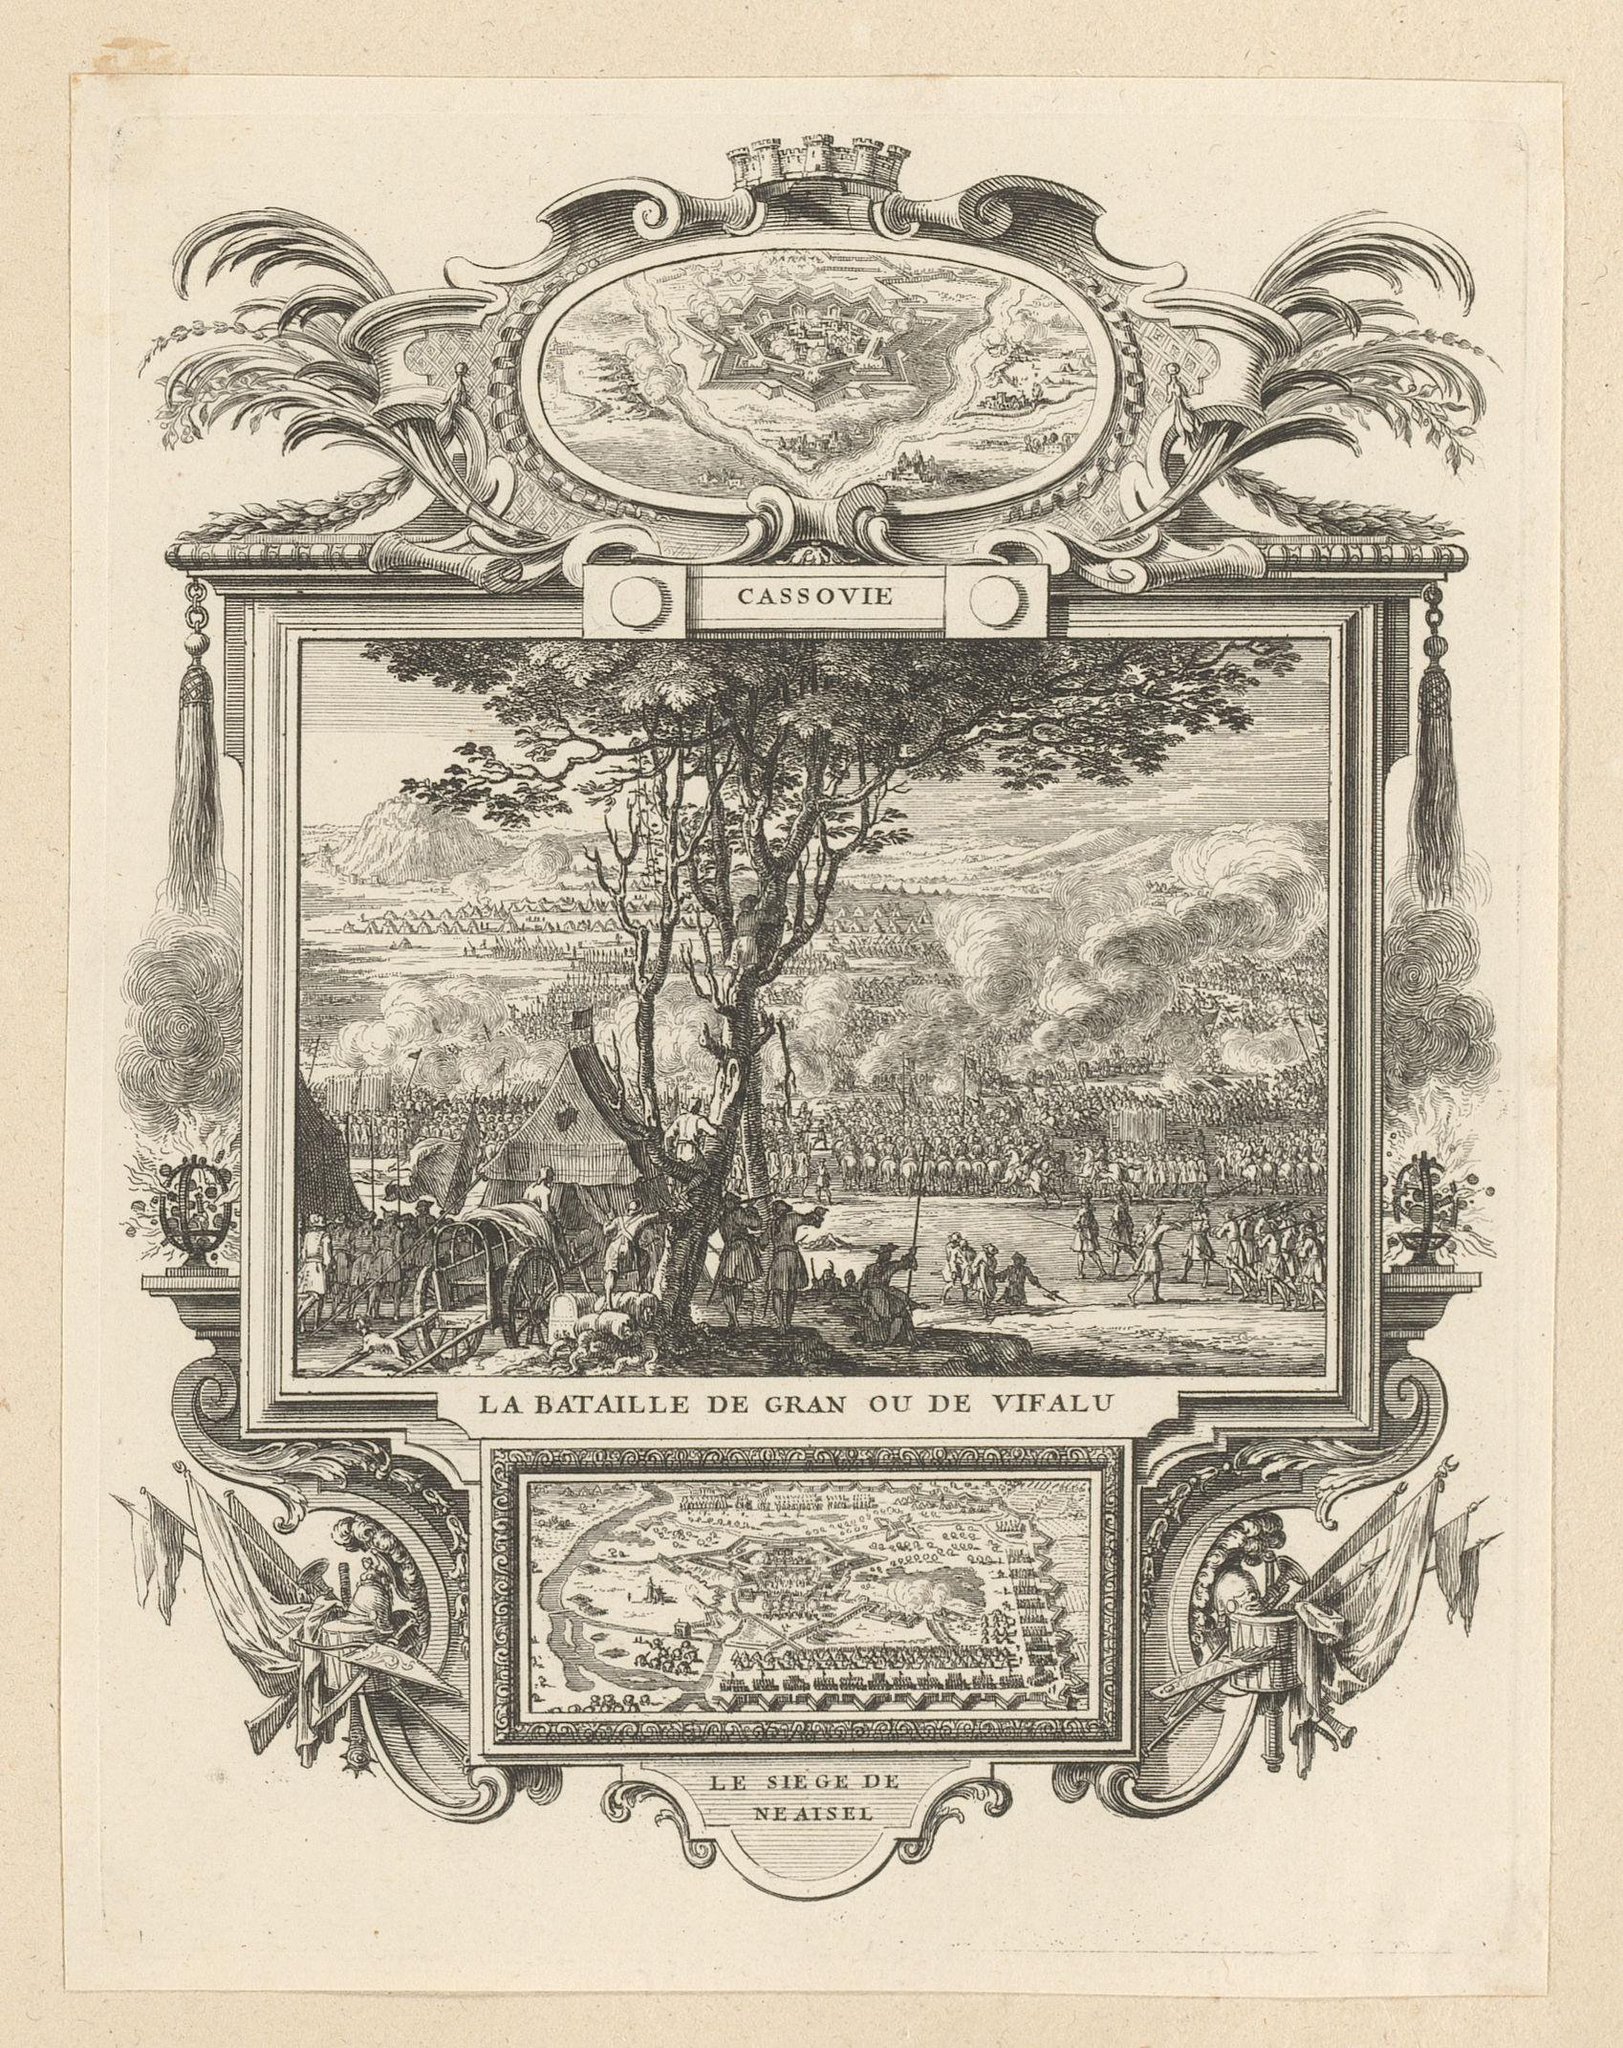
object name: print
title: La Bataille de Gran ou de Vifalu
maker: sébastien leclerc (i)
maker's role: print maker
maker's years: 1637-1714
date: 1704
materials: paper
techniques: etching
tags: vienna, historical persons, battle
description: Prent maakt deel uit van een serie van 37 prenten met veldslagen waar Karel V Leopold, hertog van Lotharingen, aan deelgenomen heeft.